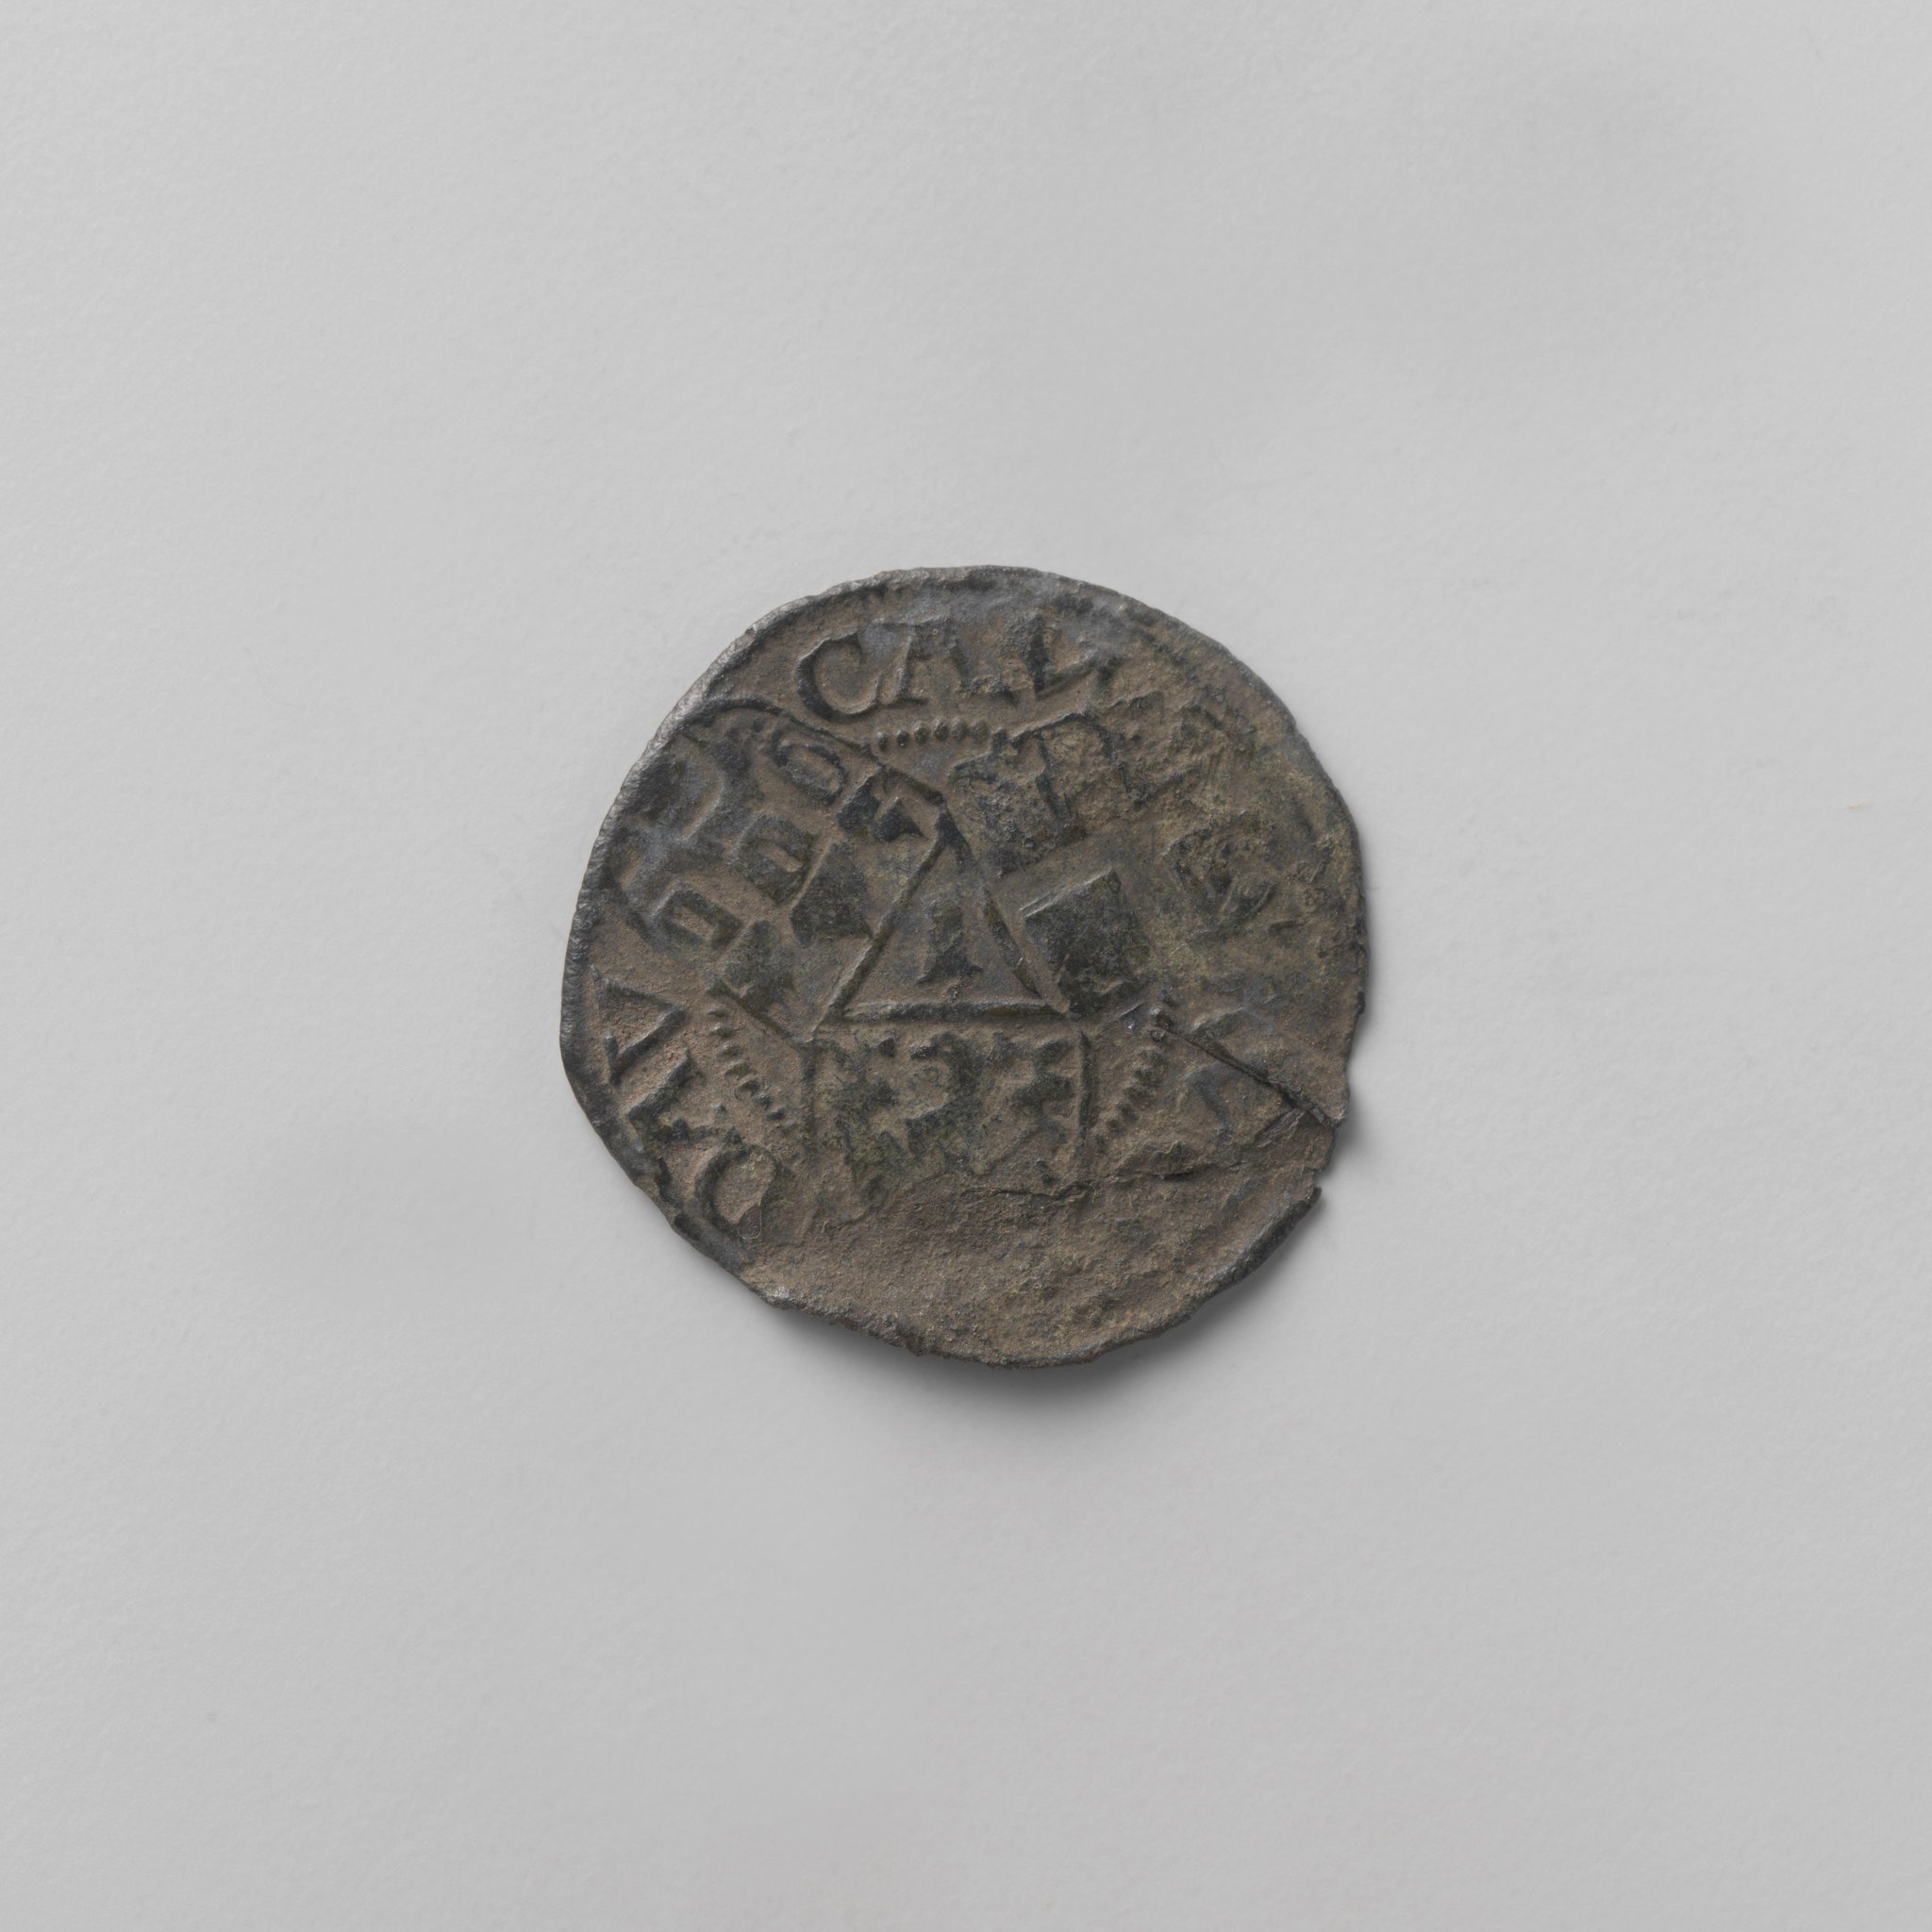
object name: coin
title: Plak van de Drie Steden, 1556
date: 1556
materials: silver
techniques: striking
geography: deventer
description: Koper-zilveren munt. Voorzijde: Wapenschild van Deventer op lang kruis. Jaartal 56 in omschrift. Keerzijde: wapenschildjes van de Drie Steden, in het centrum cijfer I.